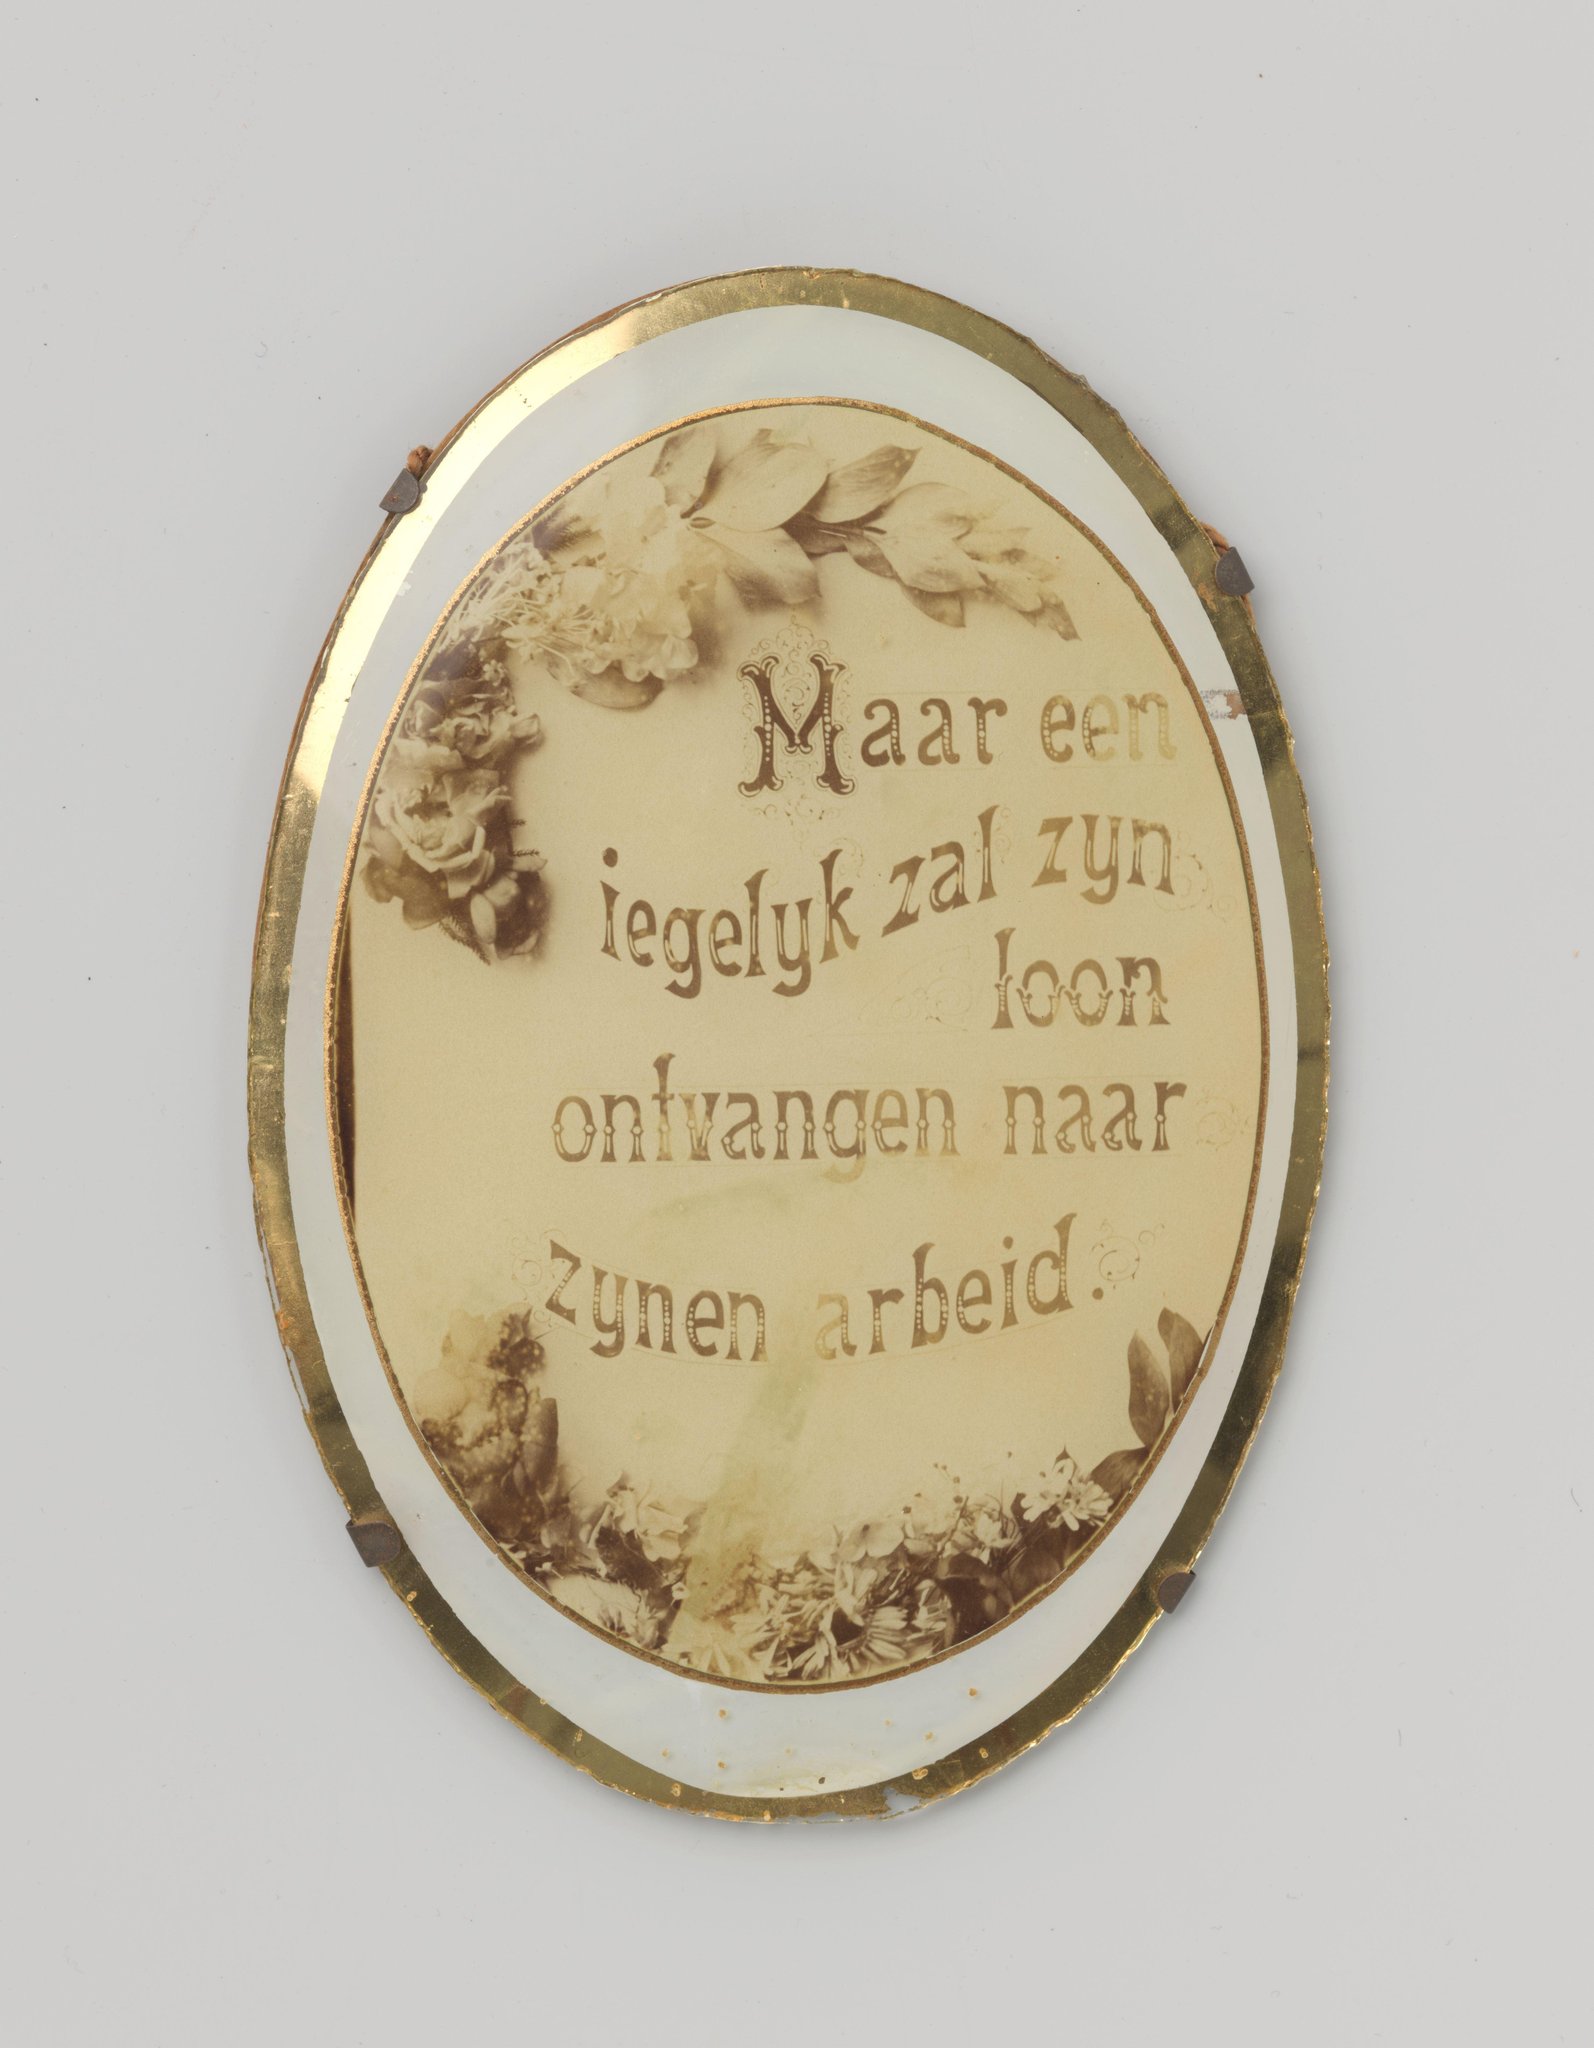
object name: photograph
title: Maar een iegelyk zal zijn loon ontvangen naar zynen arbeid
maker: Anonymous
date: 1880-1900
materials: cardboard, glass, metal, paper, fiber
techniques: albumen print